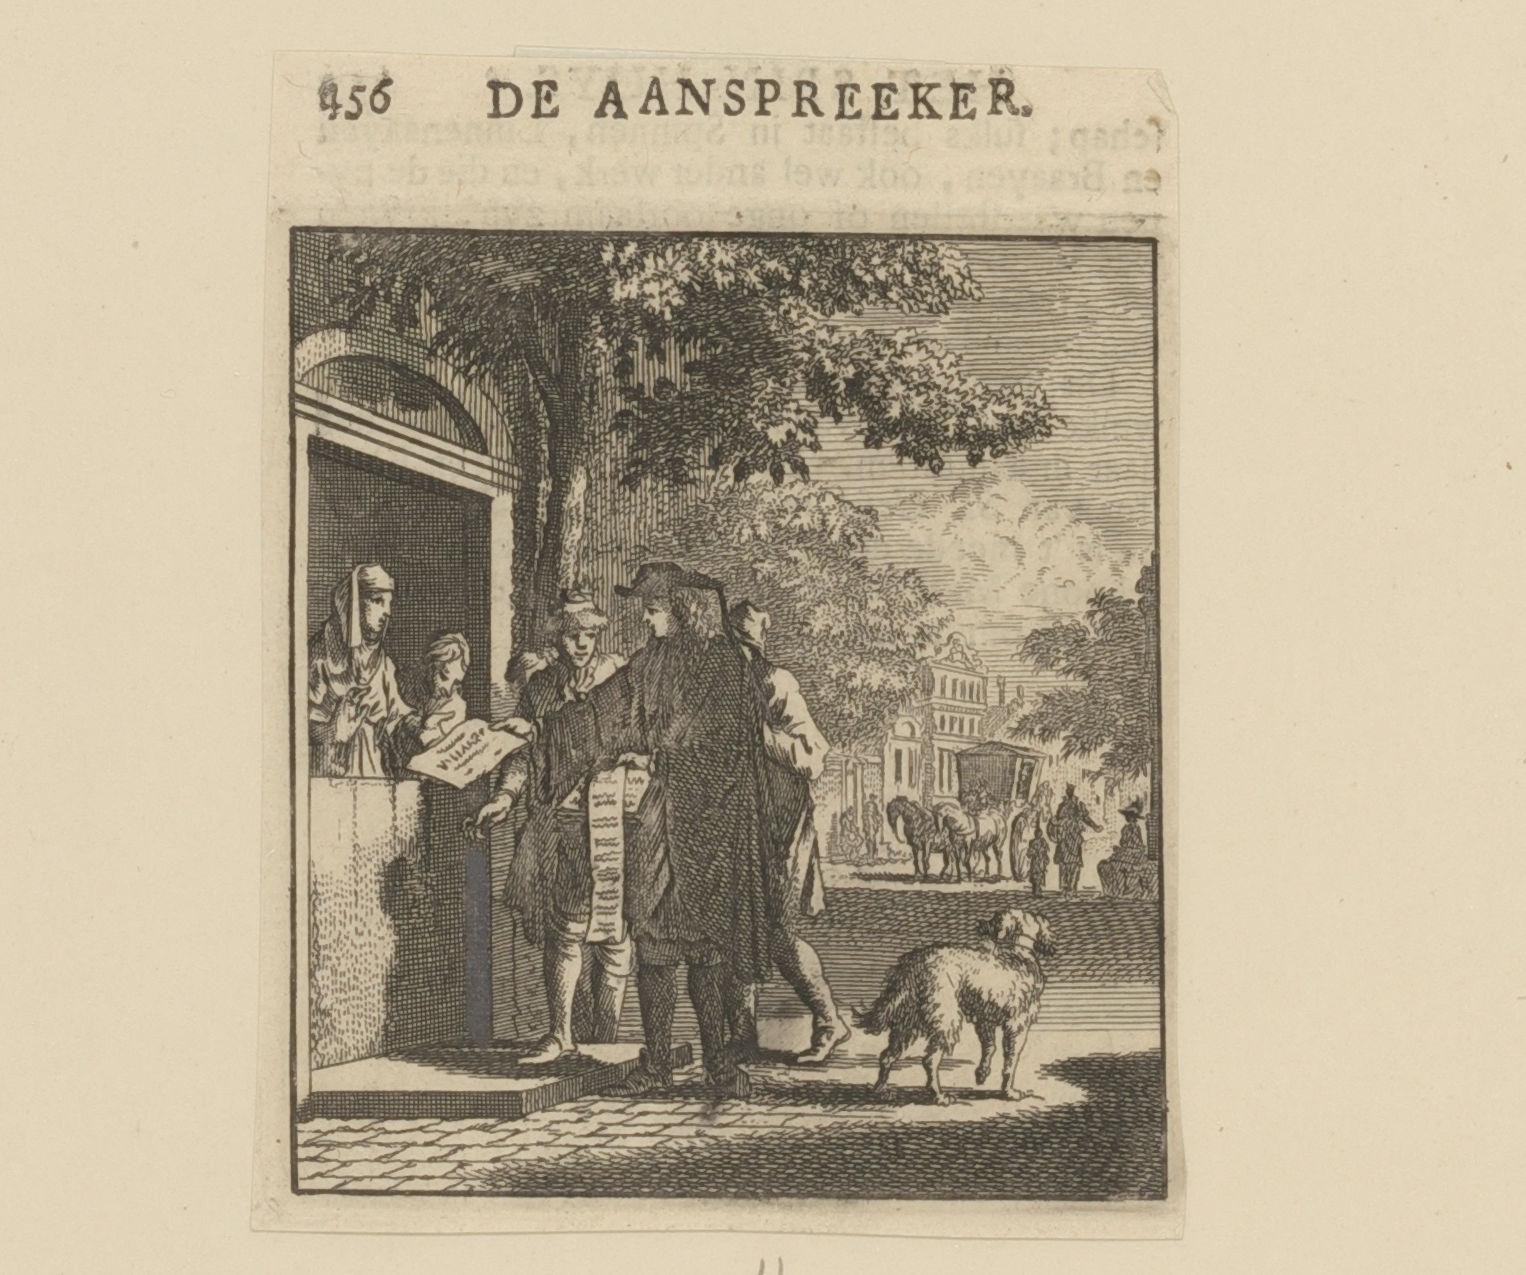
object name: print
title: De Aanspreeker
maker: Anonymous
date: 1719-1759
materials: paper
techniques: etching, letterpress printing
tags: messenger, cult of the dead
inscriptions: collector's mark: Lugt 1641, stamp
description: Prent met andere letterzetting gebruikt in: St. Clara, Abraham van. Iets voor allen. [Vertaald door] J. le Long. Amsterdam: Janssoons van Waesberge, 1719, dl. 2. En in: St. Clara, Abraham van. Iets voor allen. [Vertaald door] J. le Long. Amsterdam: Jan Roman de Jonge, 1741, dl. 2. En in: St. Clara, Abraham van. Iets voor allen. [Vertaald door] J. le Long. Amsterdam: Jan Roman, 1759, dl. 2. Huidige prent uit een andere editie. Naar een prent van: Jan Luyken.